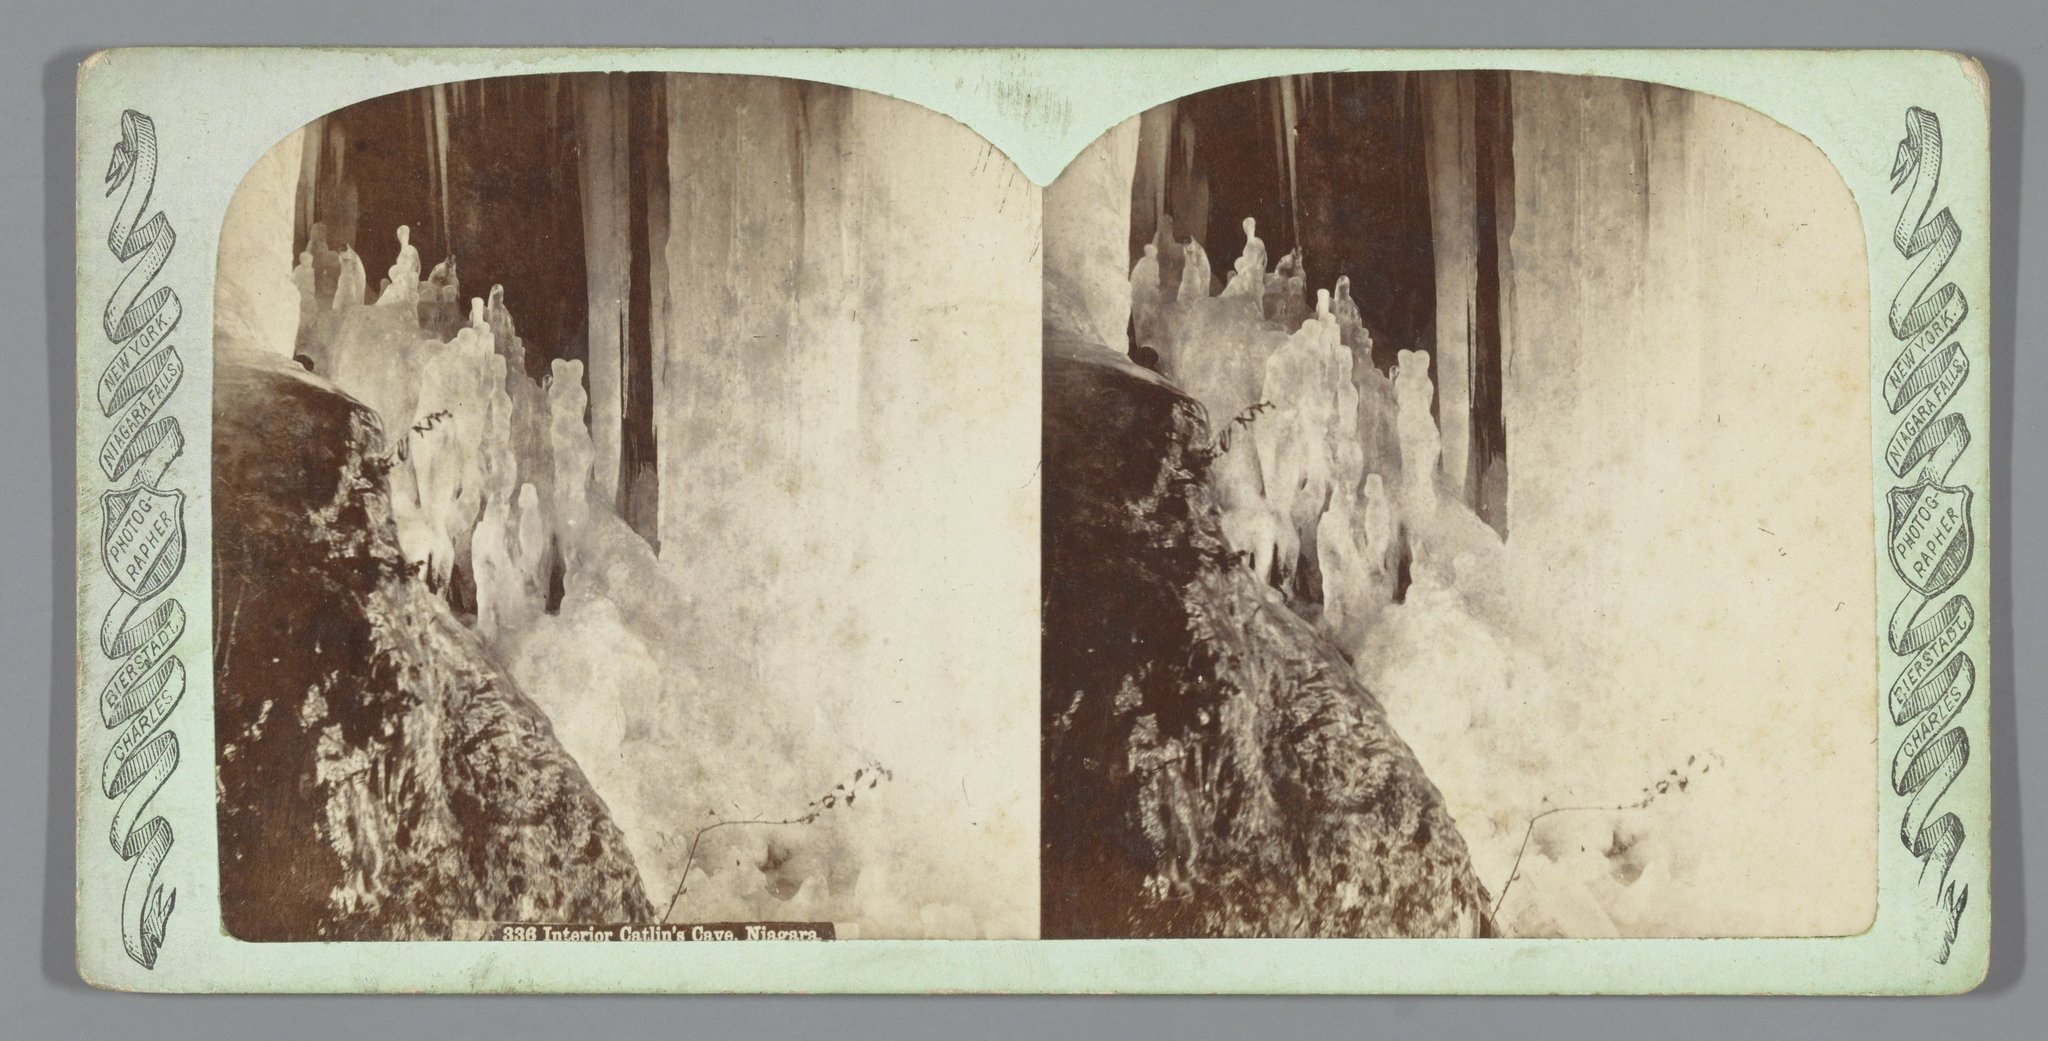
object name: stereograph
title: Interior Catlin's Cave, Niagara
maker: charles bierstadt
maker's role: publisher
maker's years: 1819-1903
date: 1867-1891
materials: cardboard, paper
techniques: albumen print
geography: niagara falls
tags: icicle, cave, grotto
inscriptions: number: ‘336’, inscription: ‘New York/ Niagara Falls/ Photographer’